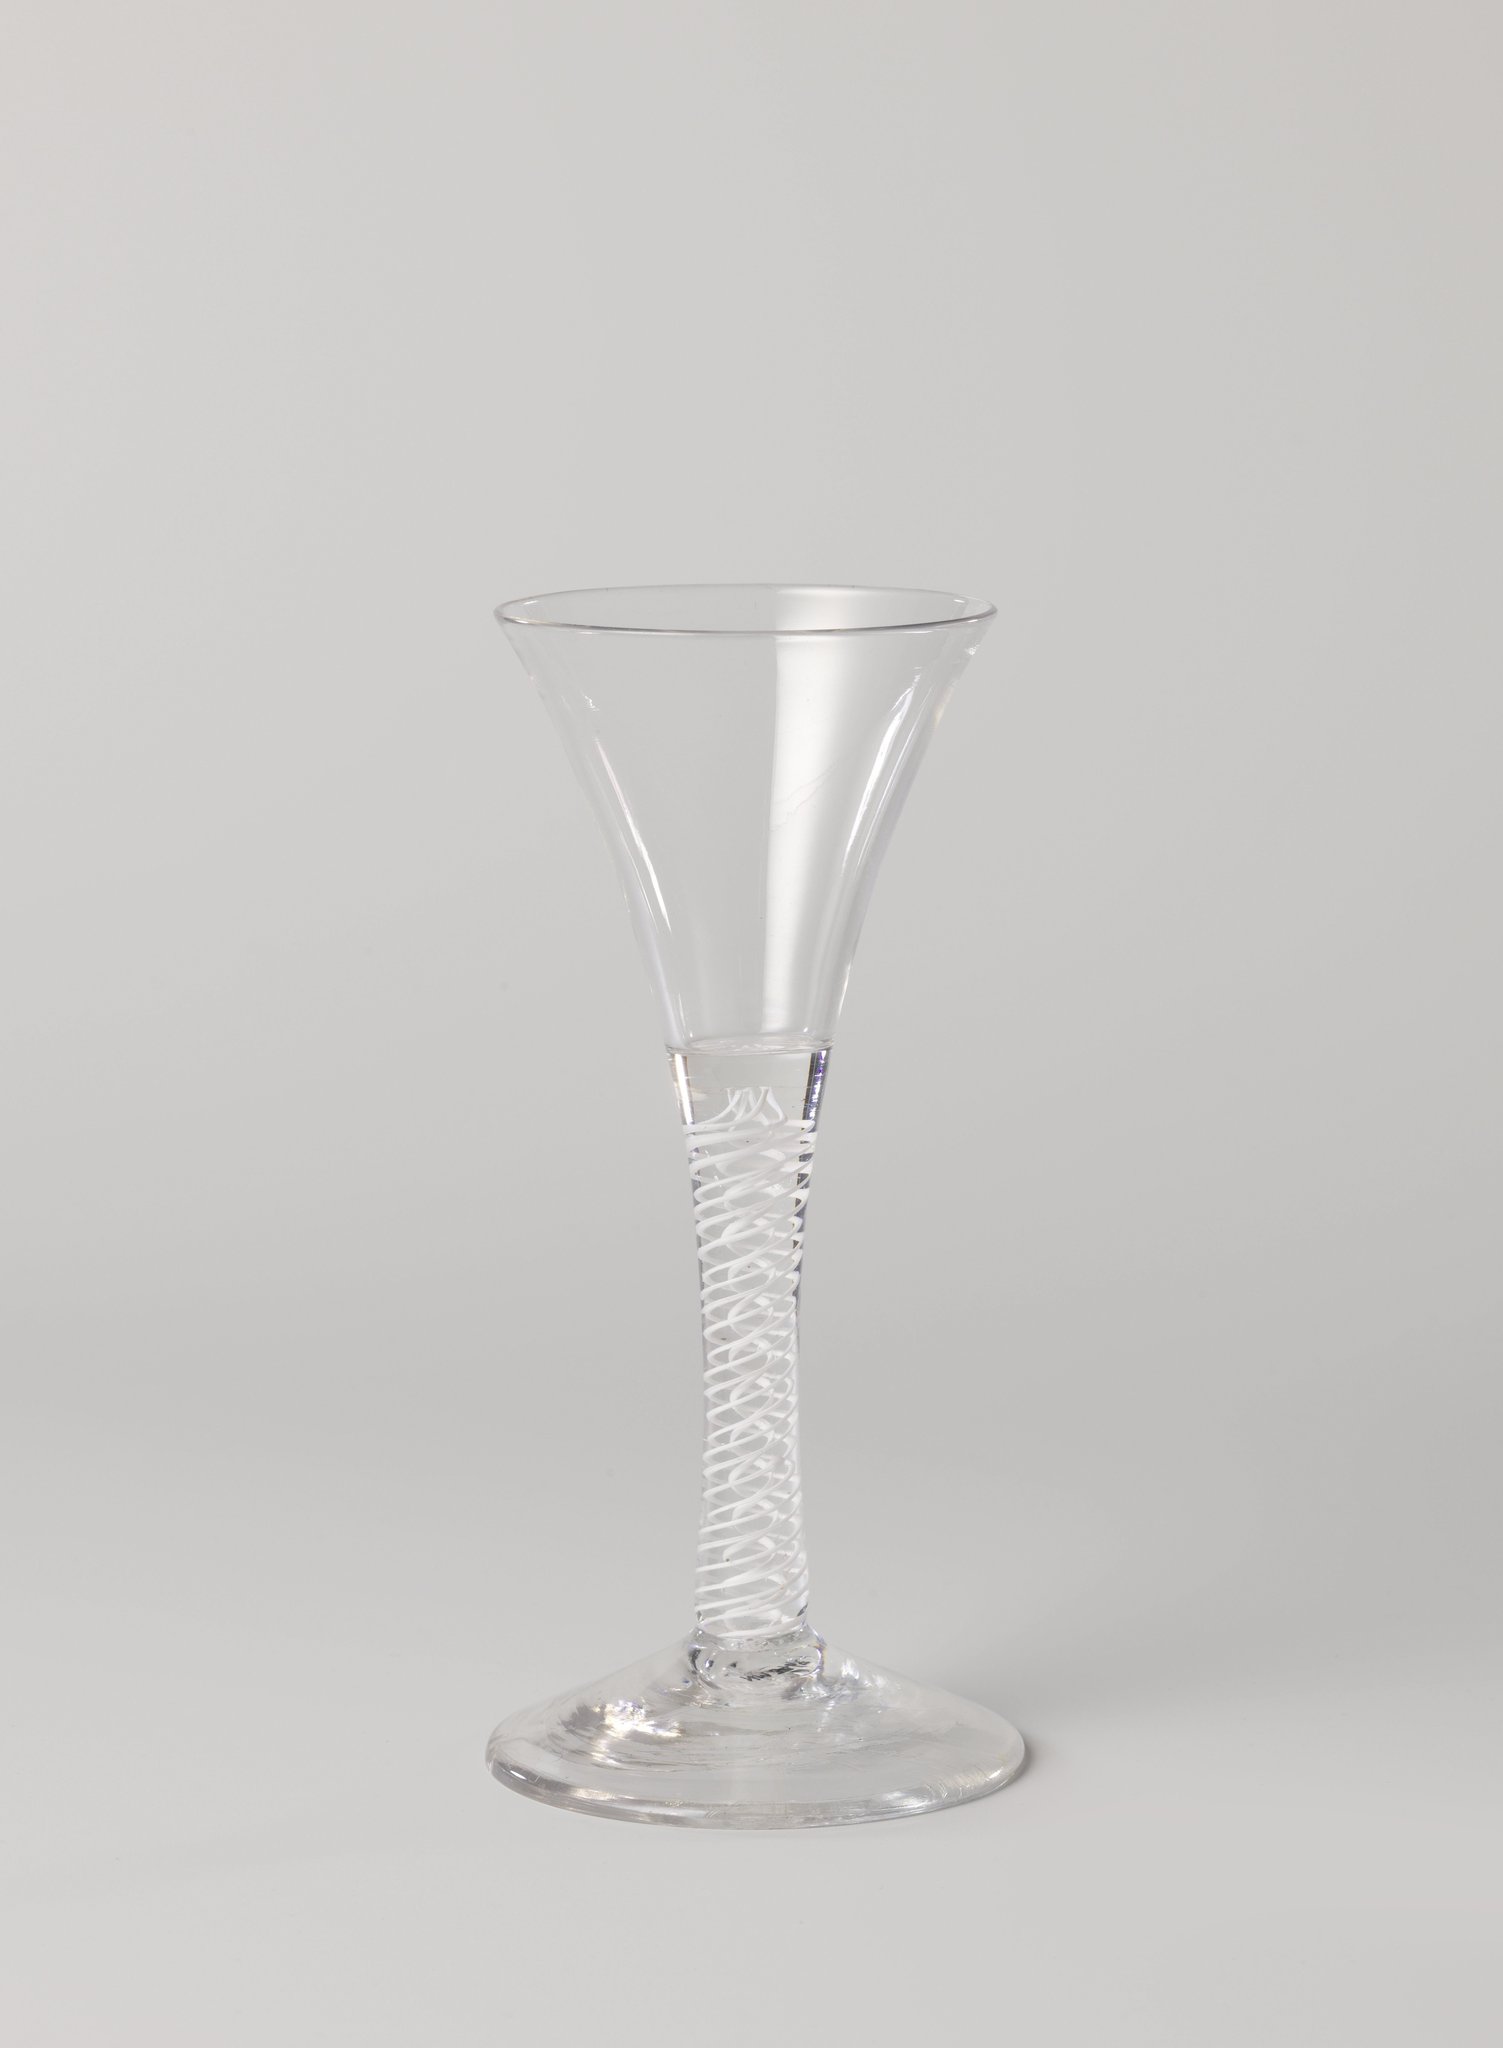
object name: goblet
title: Slingerglas met trompetvormige kelk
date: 1750-1775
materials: glass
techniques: glassblowing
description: Slingerglas met conische voet en rechte, licht concave stam. In de stam een meervoudige opaak witte slinger rond een dubbele witte spiraal, overgaand in een trompetvormige kelk.